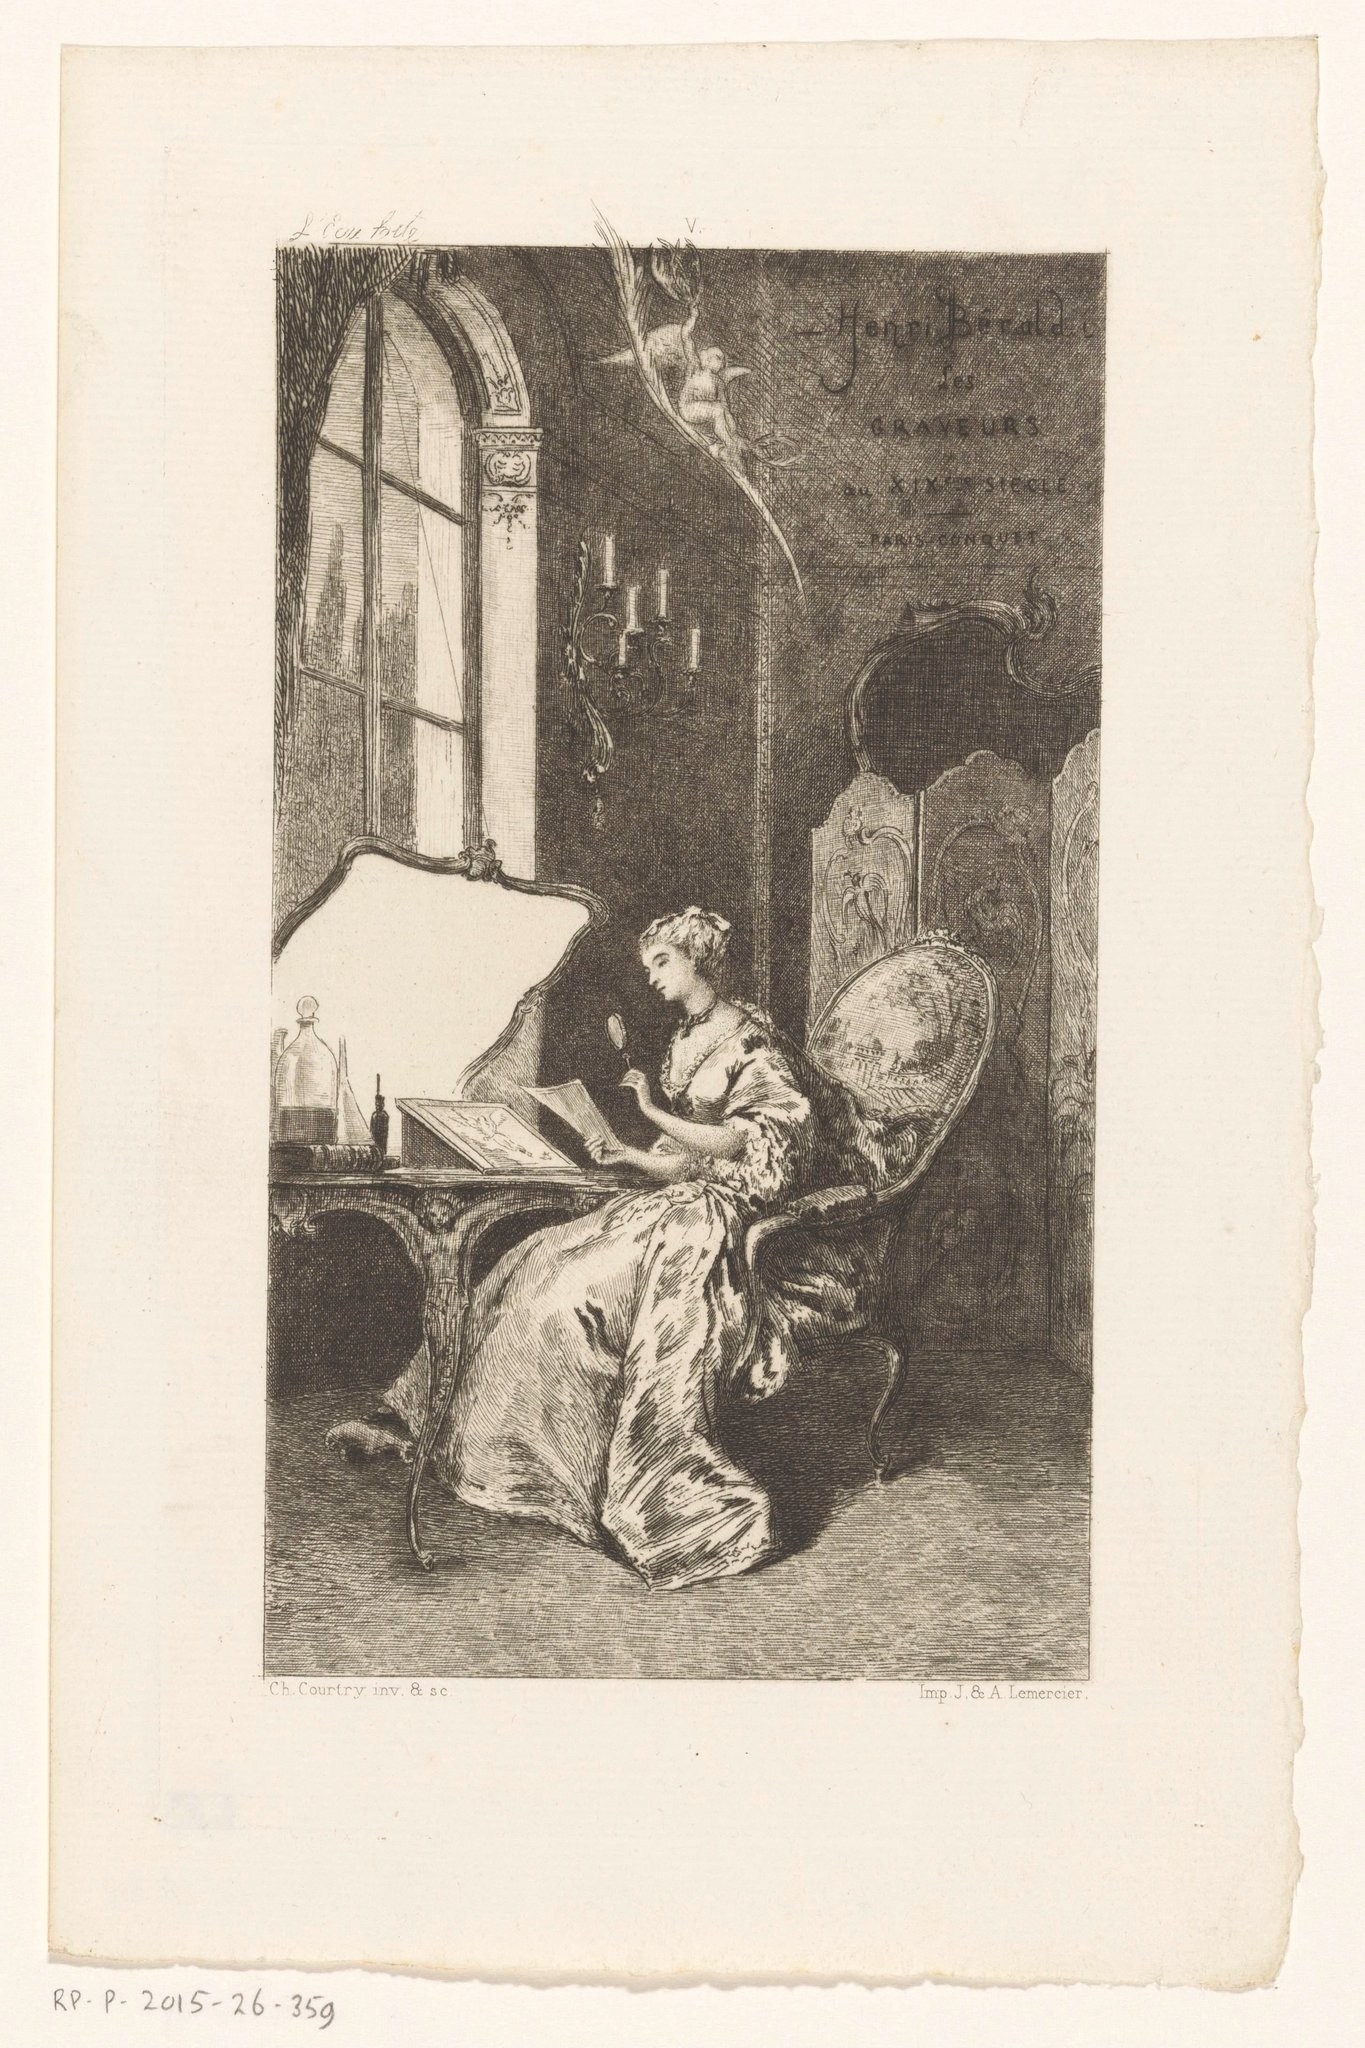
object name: titelblad, titelpagina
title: L'eau forte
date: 1886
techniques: drypoint, etching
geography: paris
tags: print, e.g.: engraving, etching, lithograph, artist at work, in his workshop (+ graphic arts), tools, implements of graphic artist, workshop, studio of the artist (in general), screen, folding screen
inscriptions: collector's mark: Lugt 2228, collector's mark: Lugt 4780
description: Achttiende-eeuwse voorstelling. Een vrouw zit achter een tafel van een prentmaker voor een raam. In de achtergrond een kamerscherm, uit de lucht daalt een allegorisch figuur met vleugels op een palmtak neer.